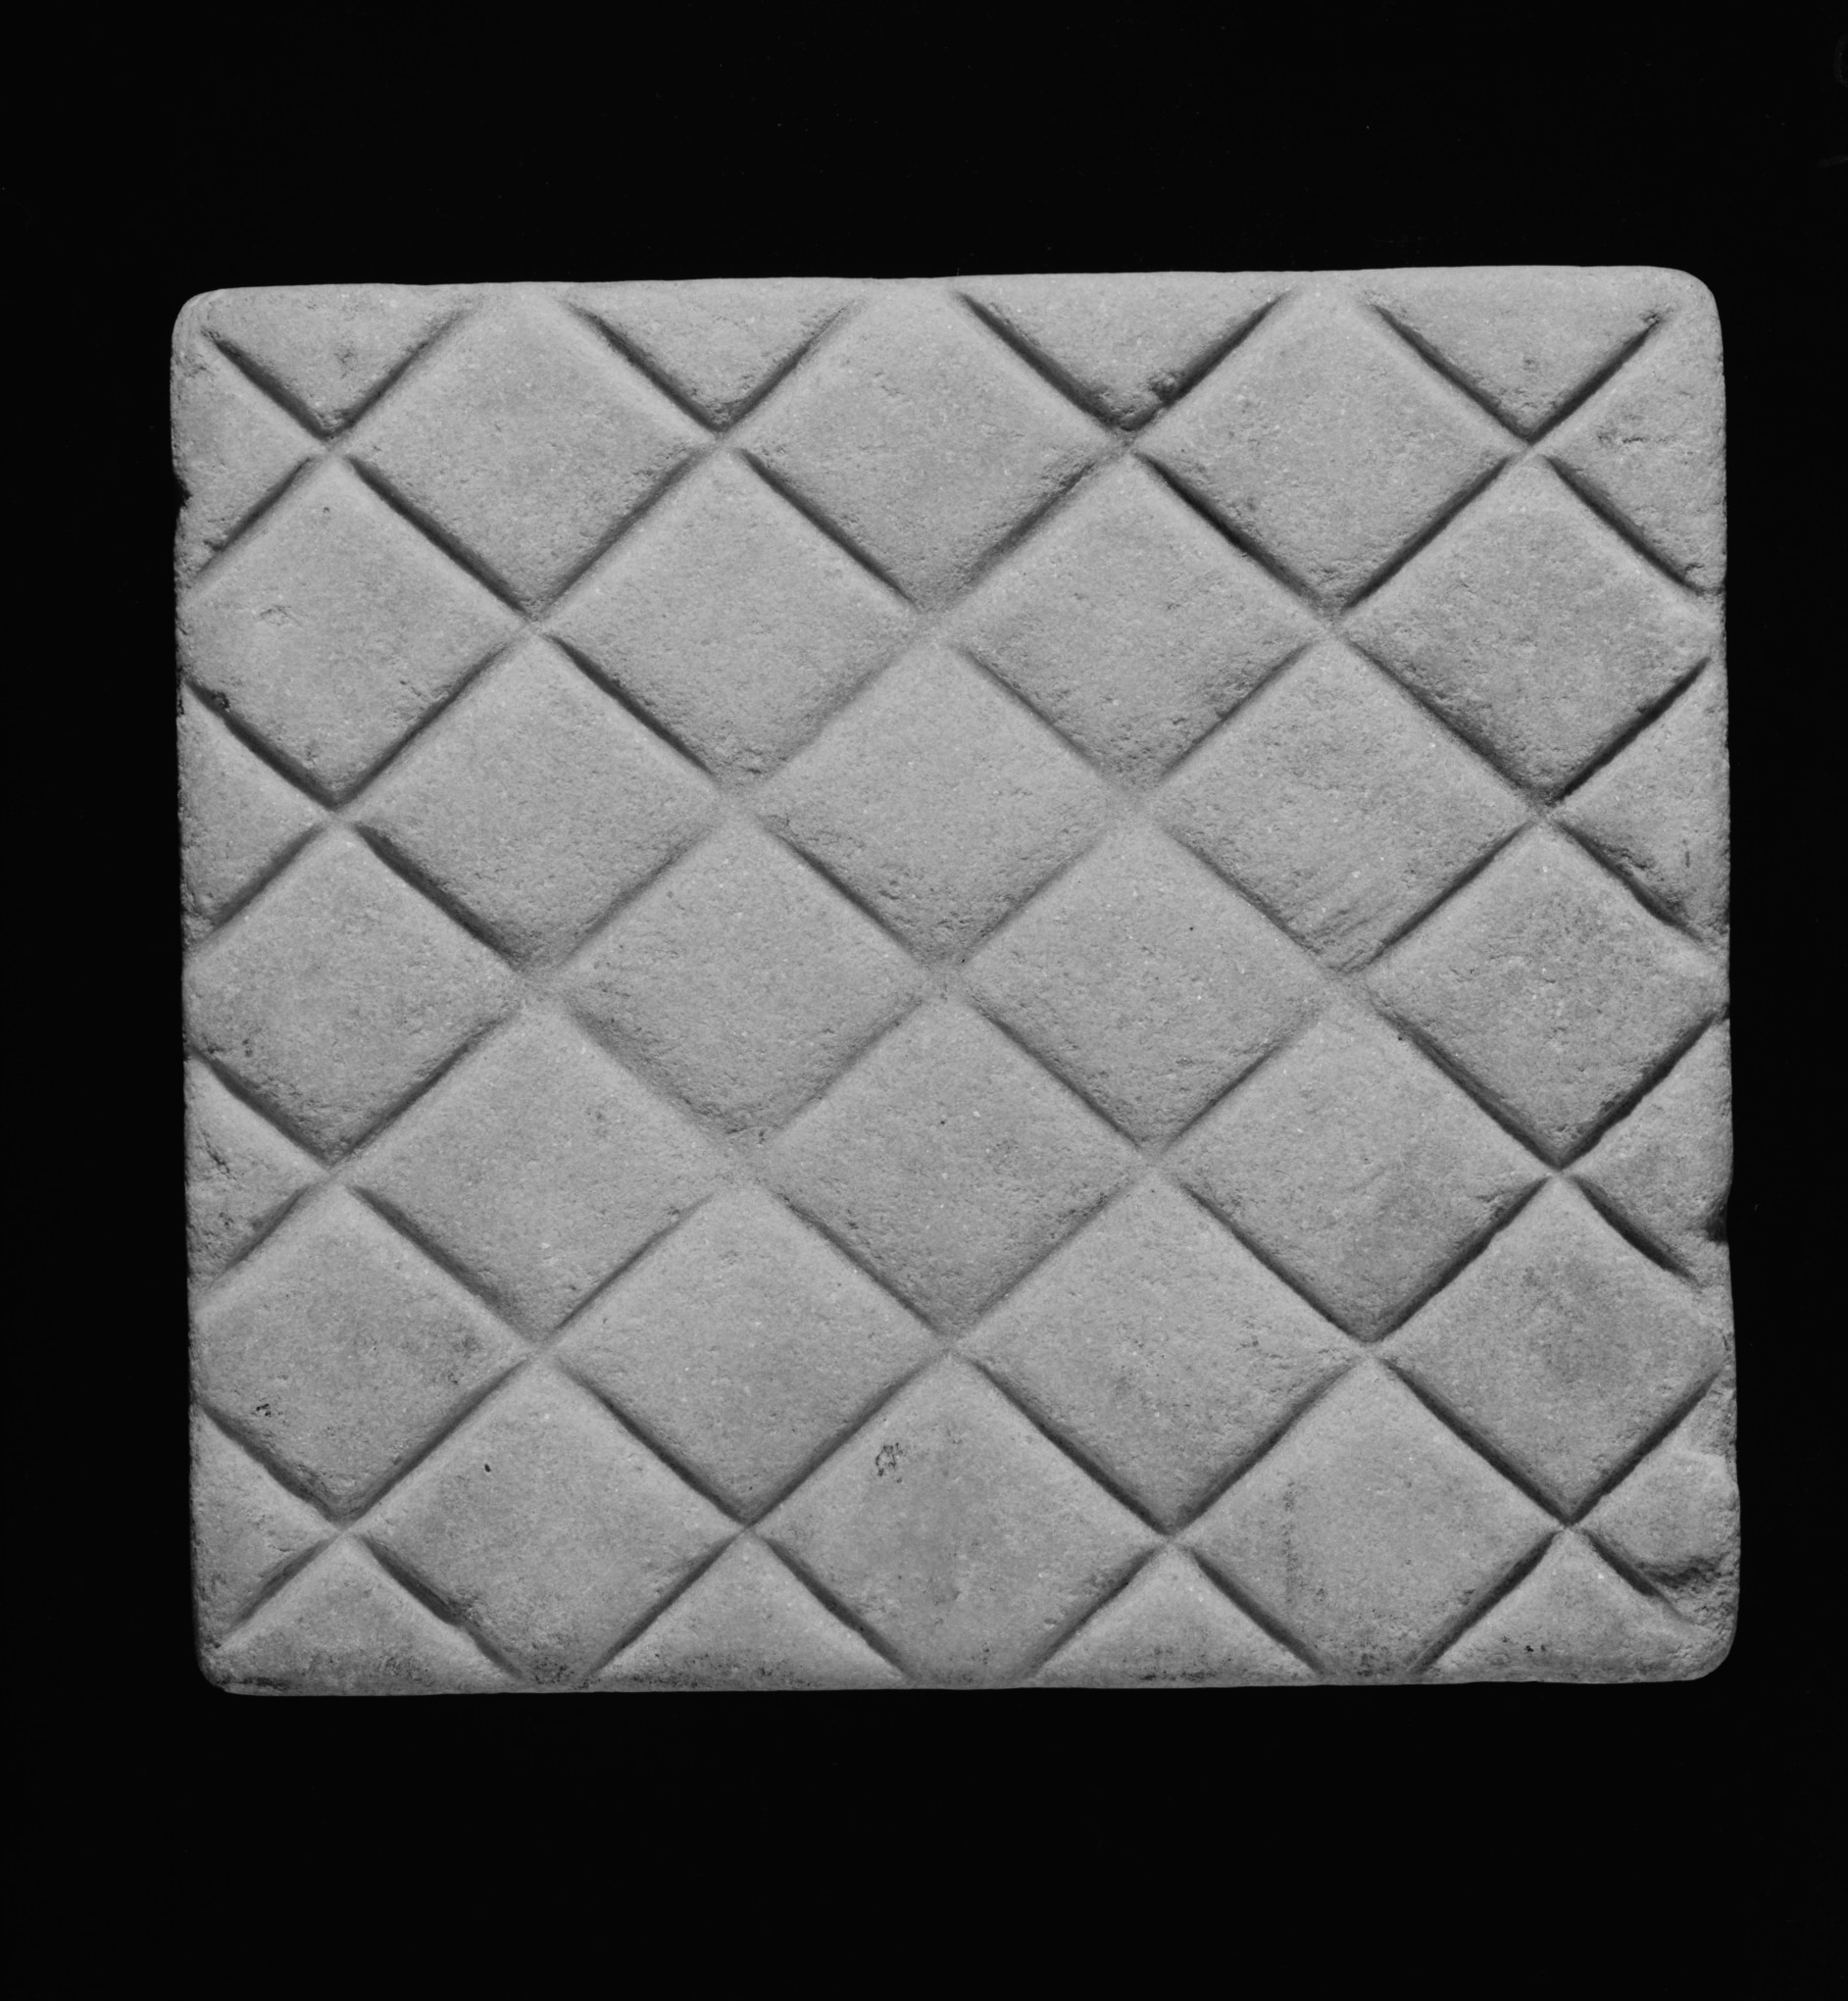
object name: fireplace stand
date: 1800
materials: marble